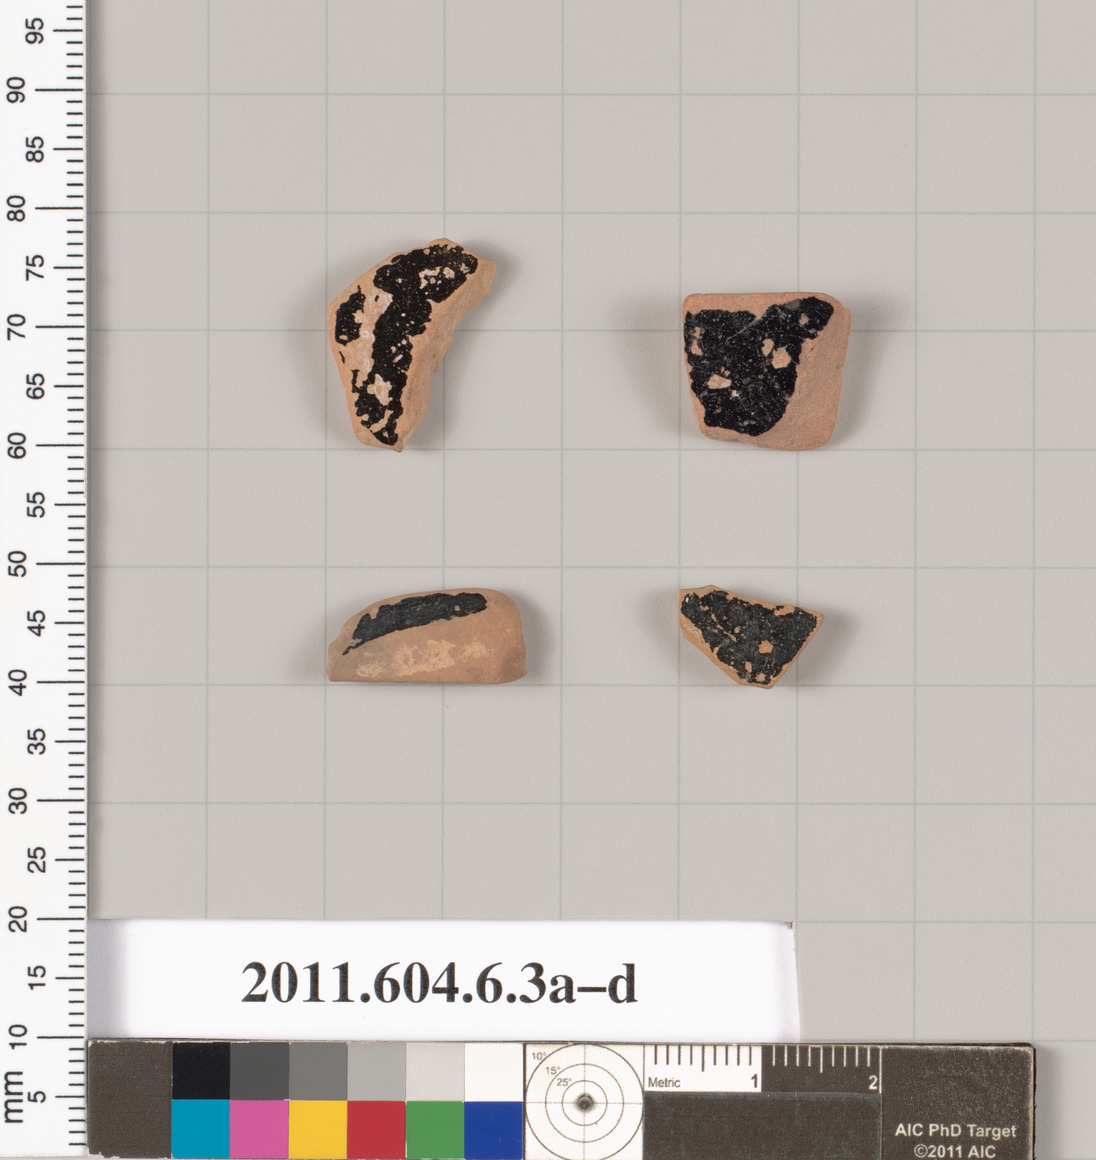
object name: undetermined open shape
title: Terracotta fragments of open shapes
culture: greek, attic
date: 600-401 BCE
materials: terracotta